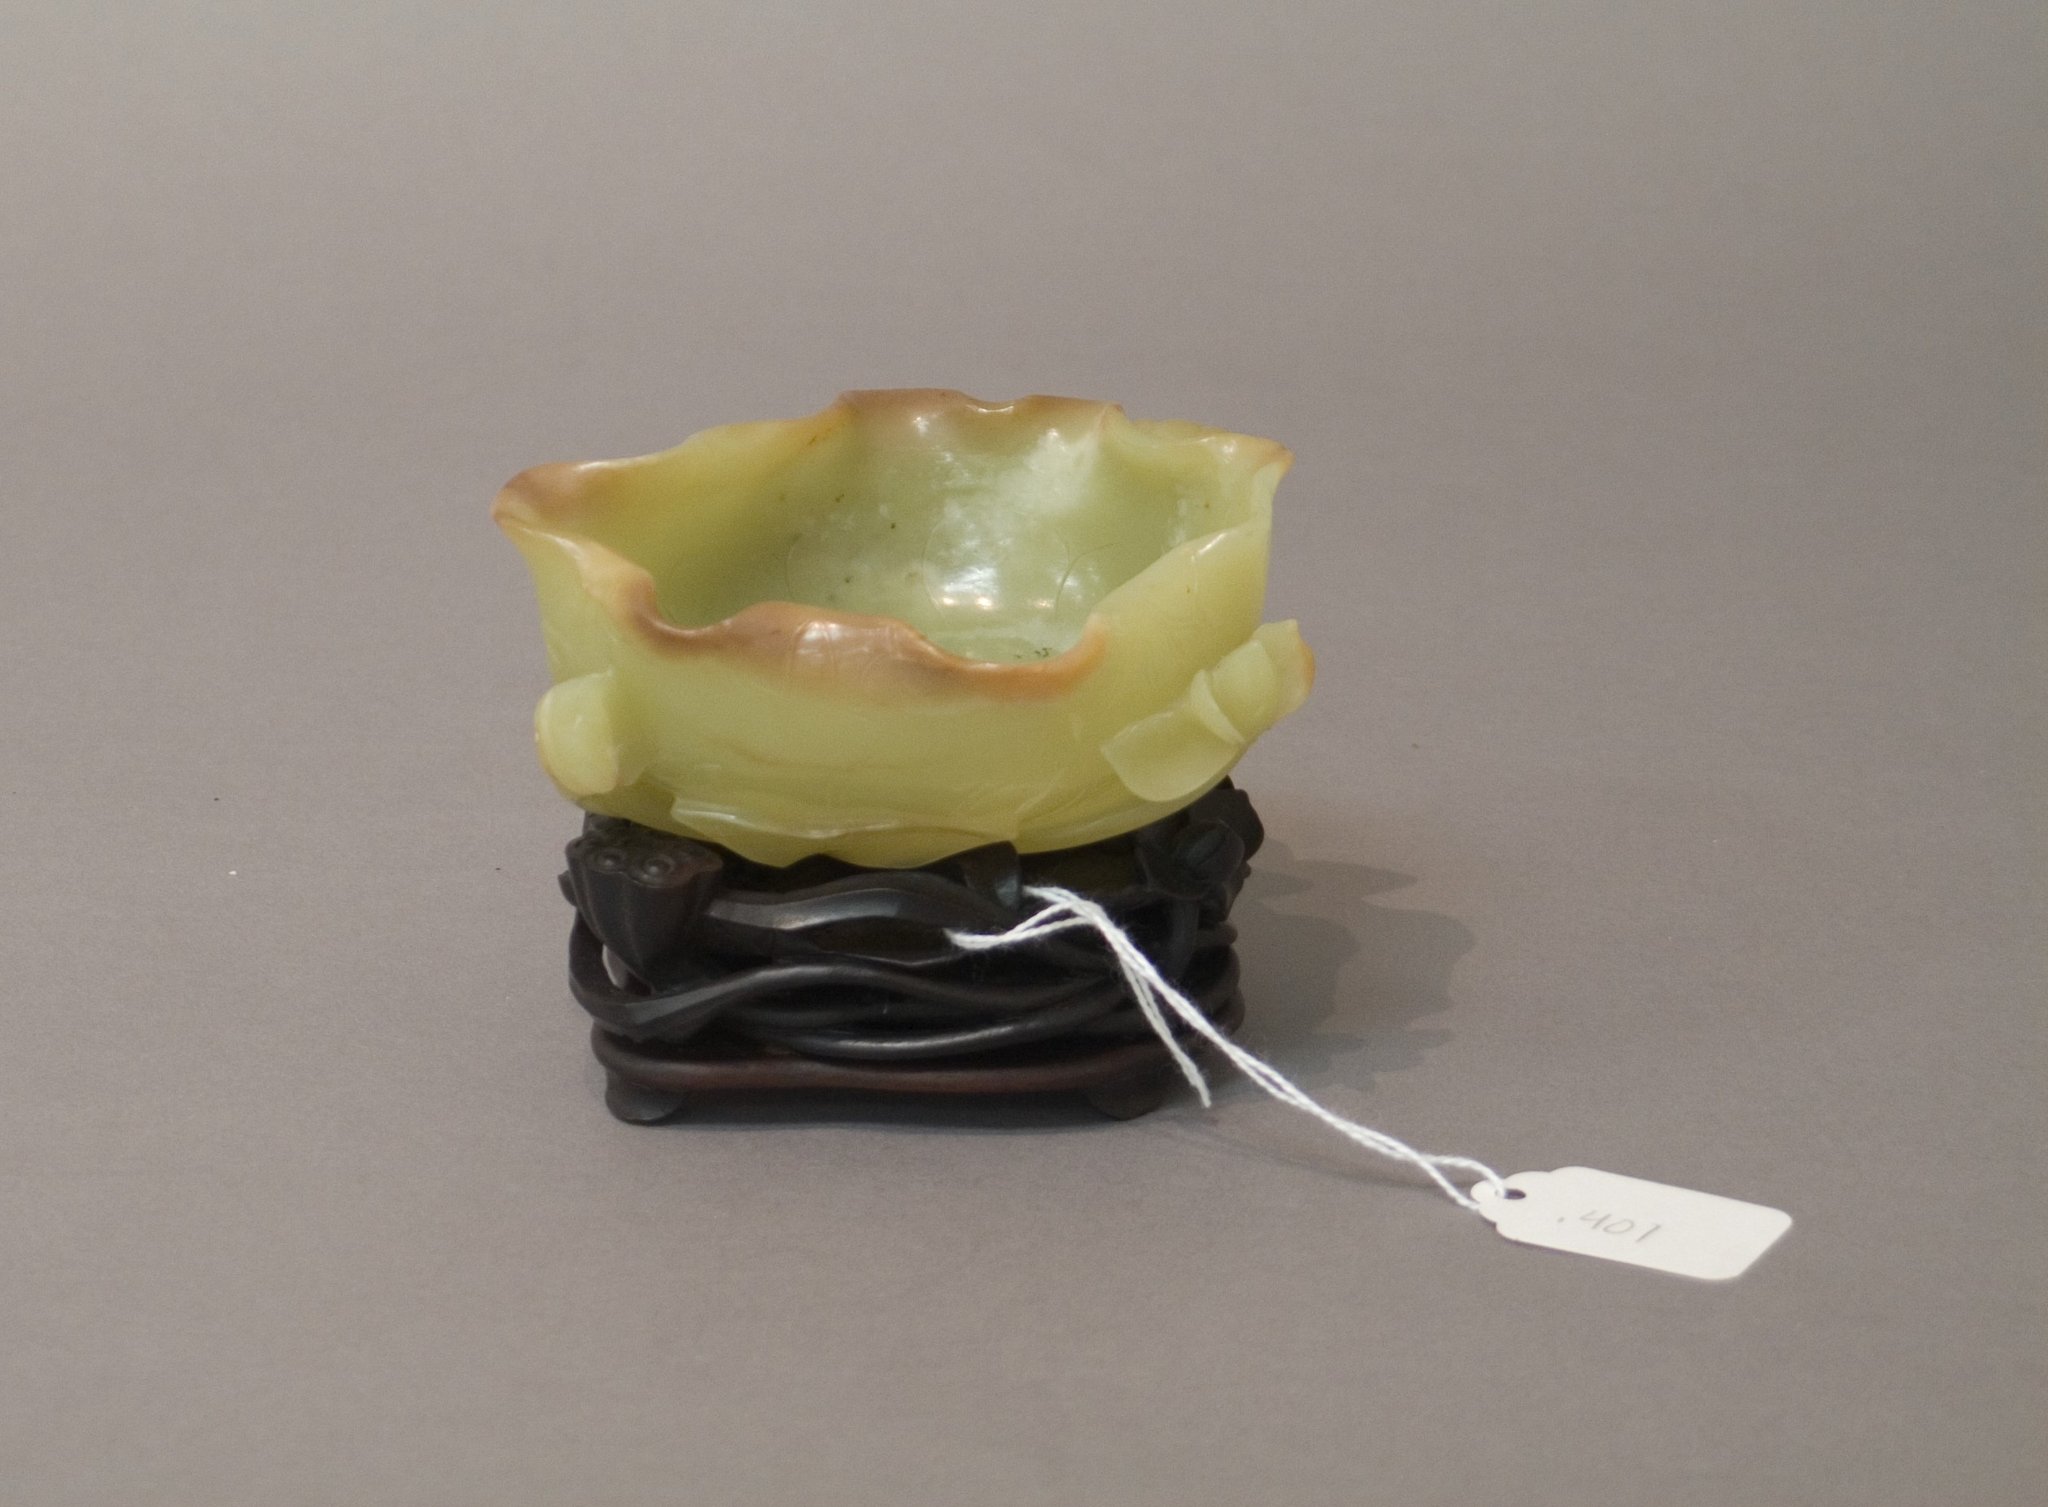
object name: wine cup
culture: chinese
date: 1368-1644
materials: jade